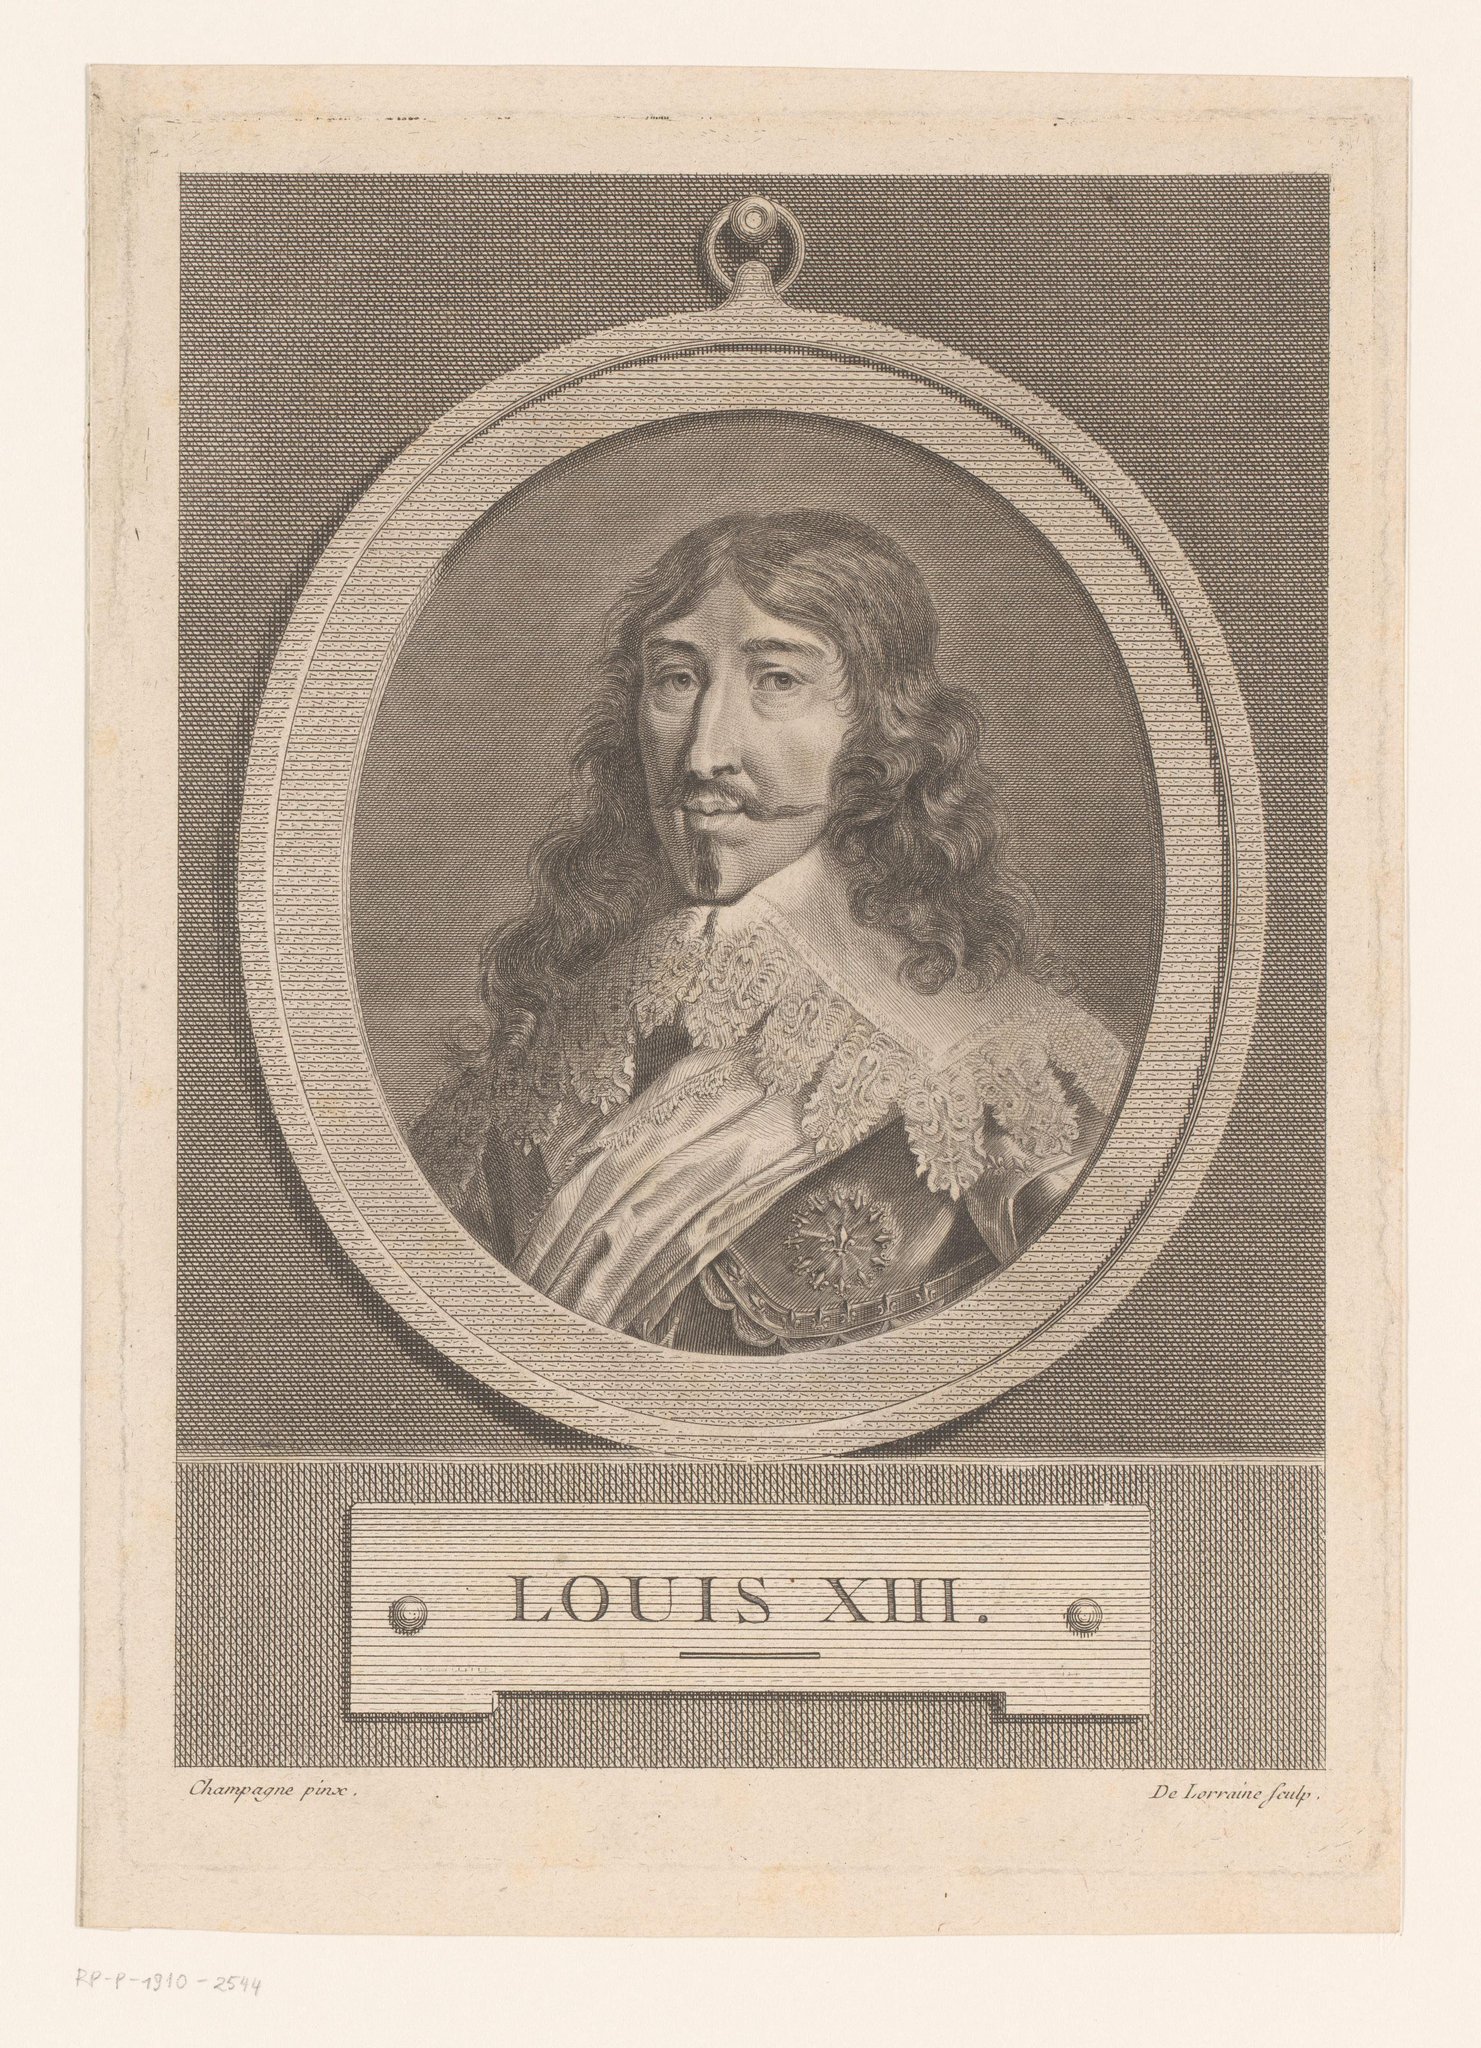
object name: print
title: Portret van Lodewijk XIII van Frankrijk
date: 1747-1837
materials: paper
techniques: engraving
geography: france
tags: lodewijk xiii (koning van frankrijk), historical persons, ruler, sovereign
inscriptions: collector's mark: Lugt 2228